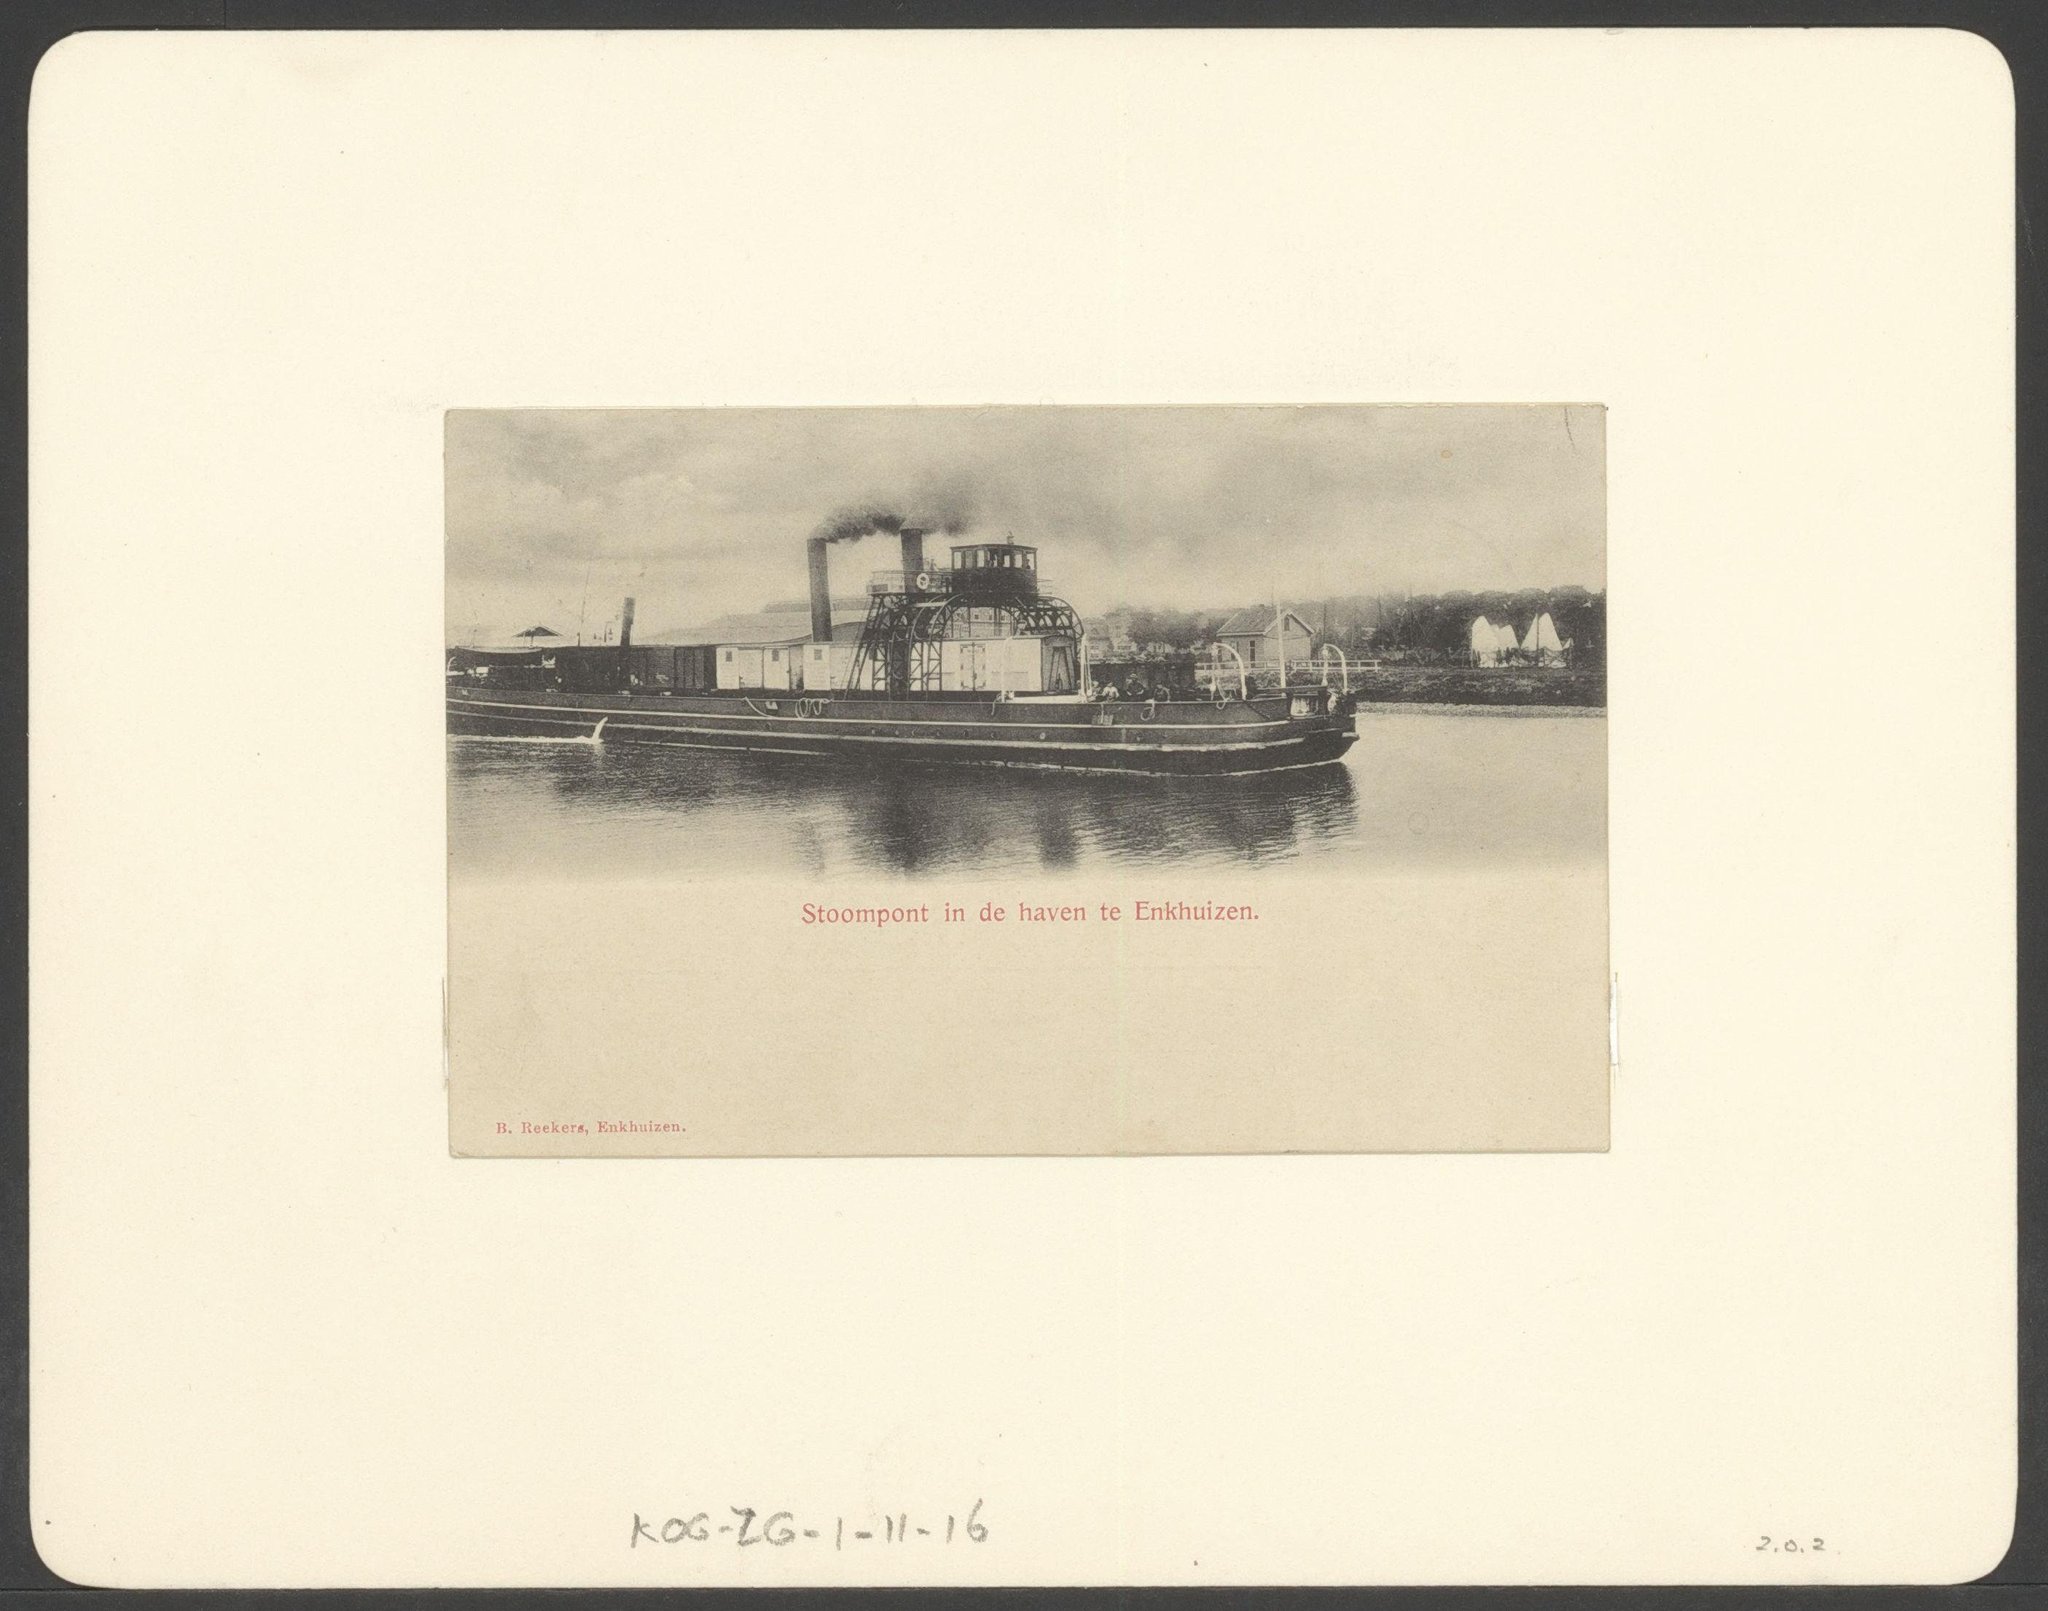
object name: photomechanical print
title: Treinveerpont in de haven van Enkhuizen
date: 1899-1954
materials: paper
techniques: photograph, letterpress printing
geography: enkhuizen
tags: passenger liner, ferry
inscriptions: collector's mark, stamp, collector's mark: Lugt 1641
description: De stoompont te Enkhuizen is een treinveer. Tussen 1899 tot 1936 voer de treinveer tussen de treinstations Enkhuizen en Stavoren. Onderwerpsrubrieken binnen de Atlas Zeden en Gewoonten: Handel, nijverheid en verkeer, Vervoermiddelen te land en te water, Vervoermiddelen te water.